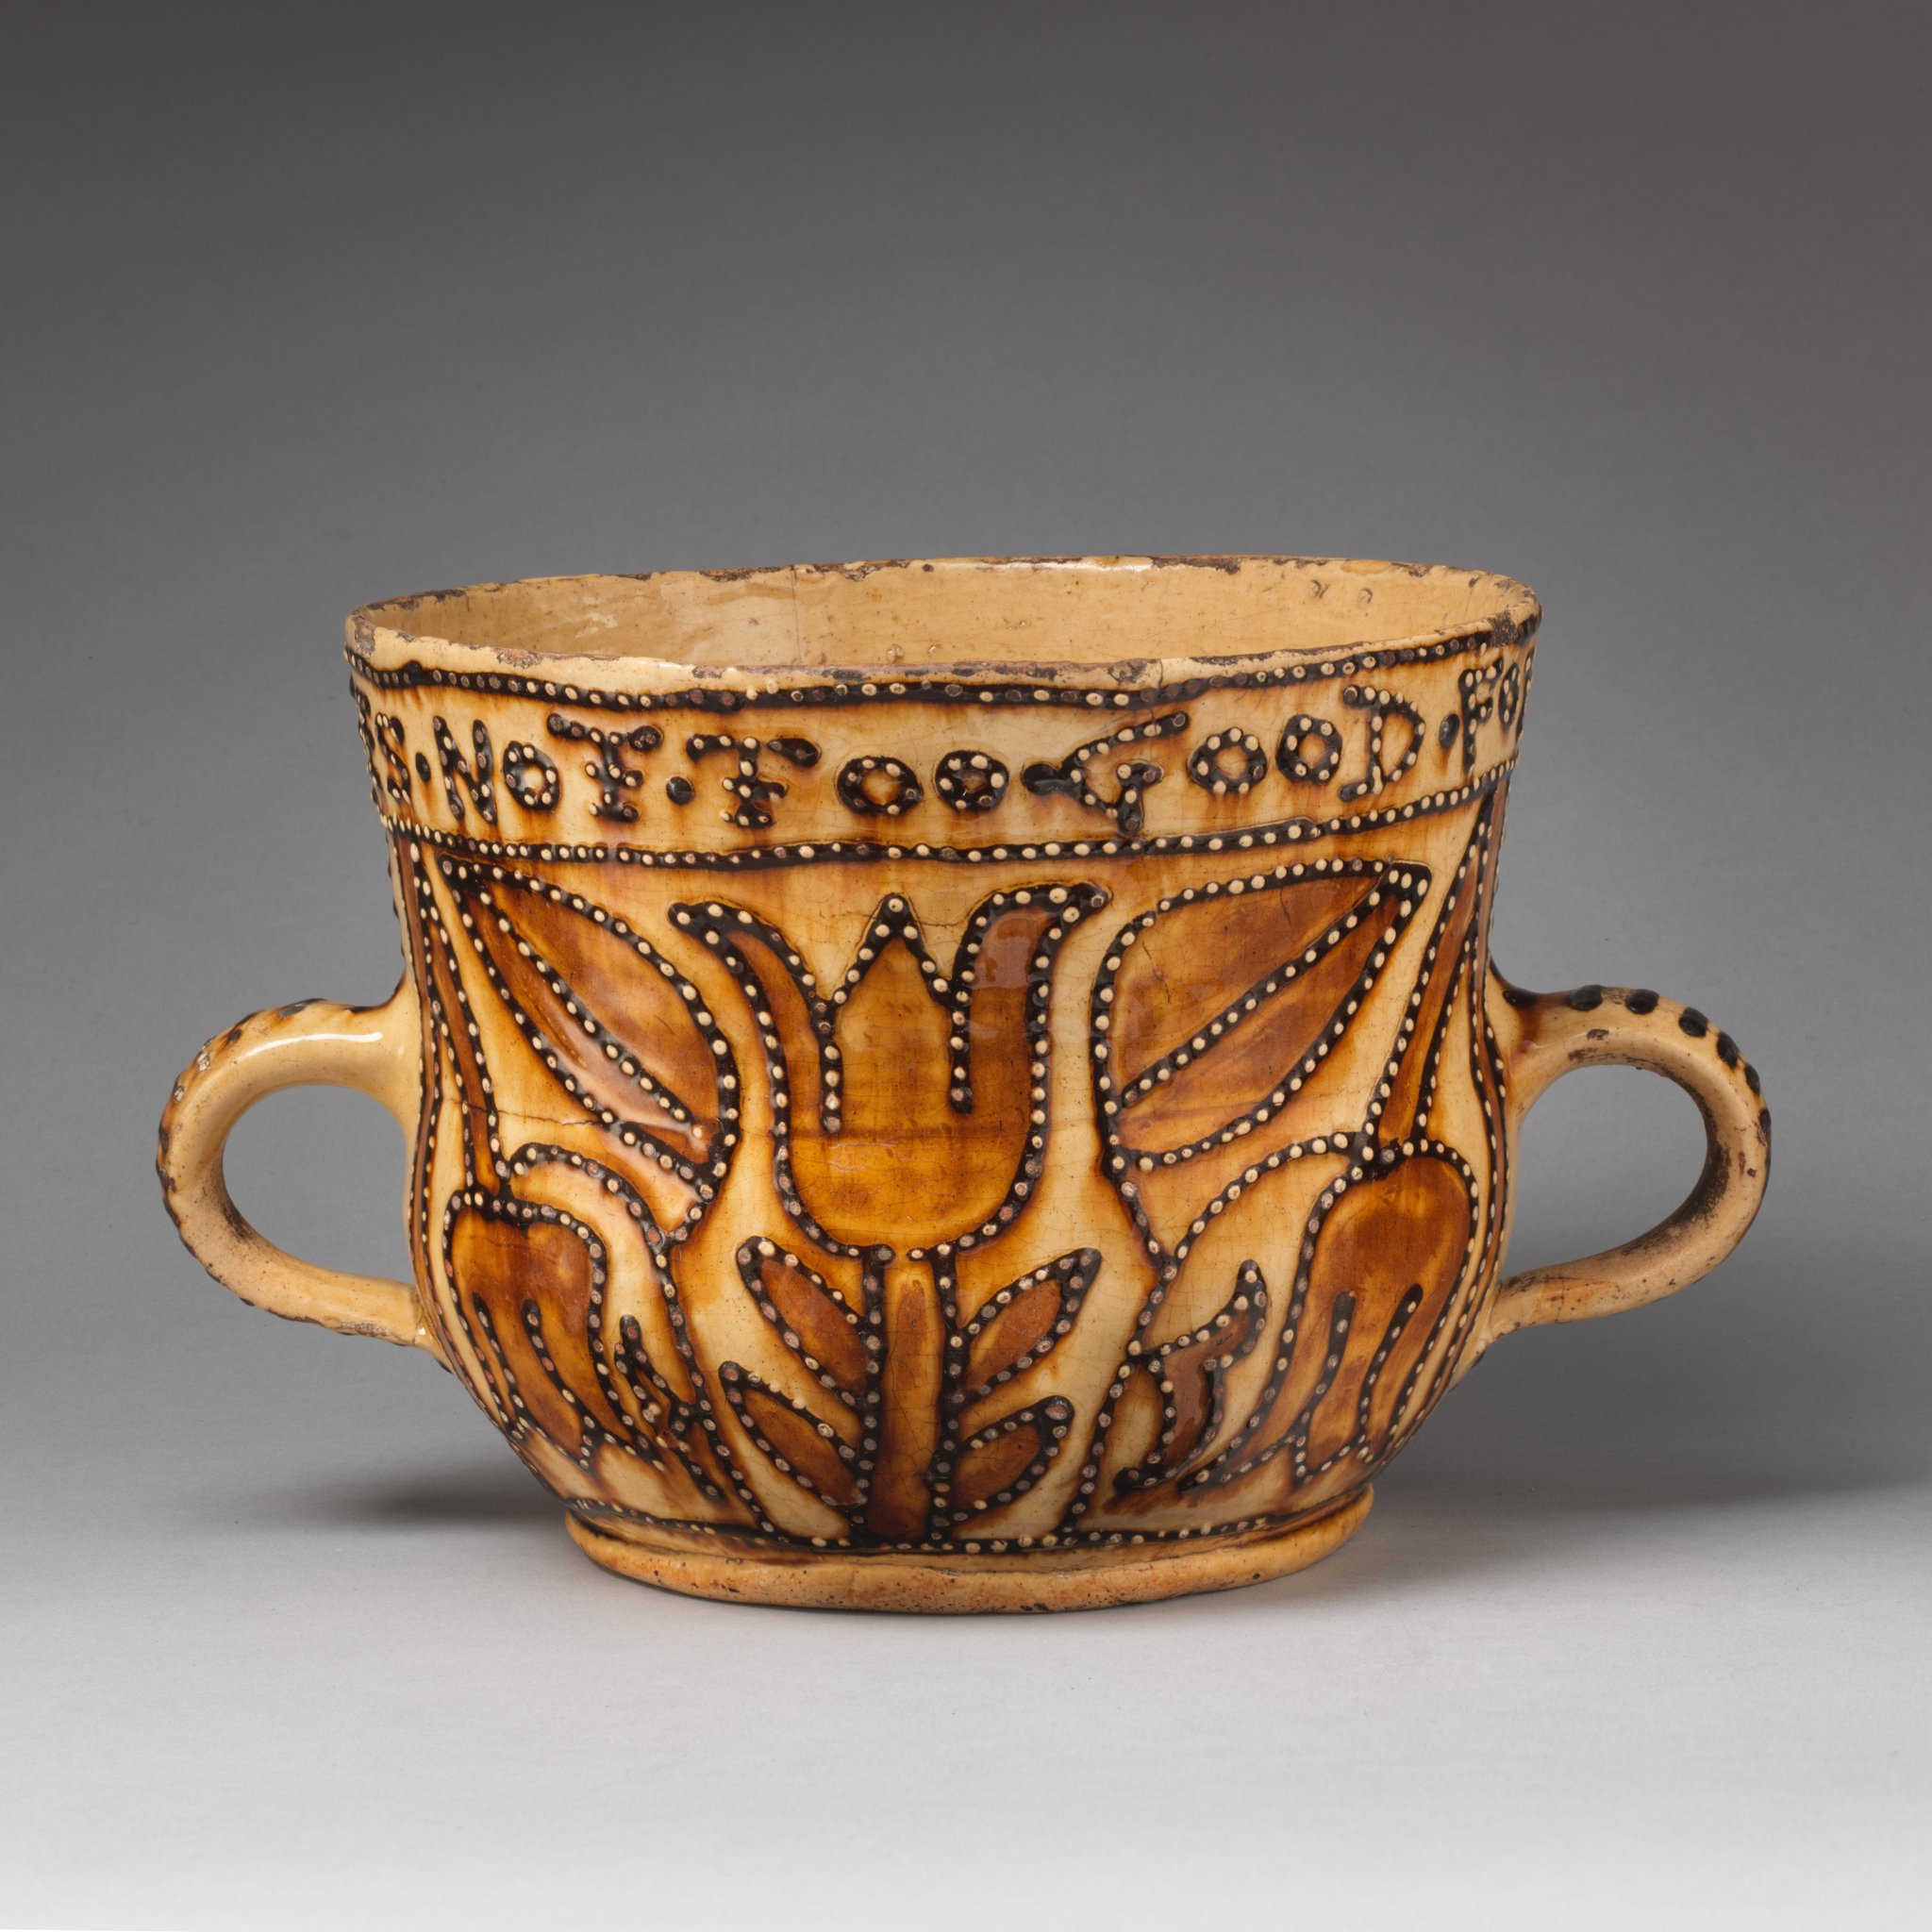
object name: posset pot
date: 1710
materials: earthenware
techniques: glazing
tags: tulips